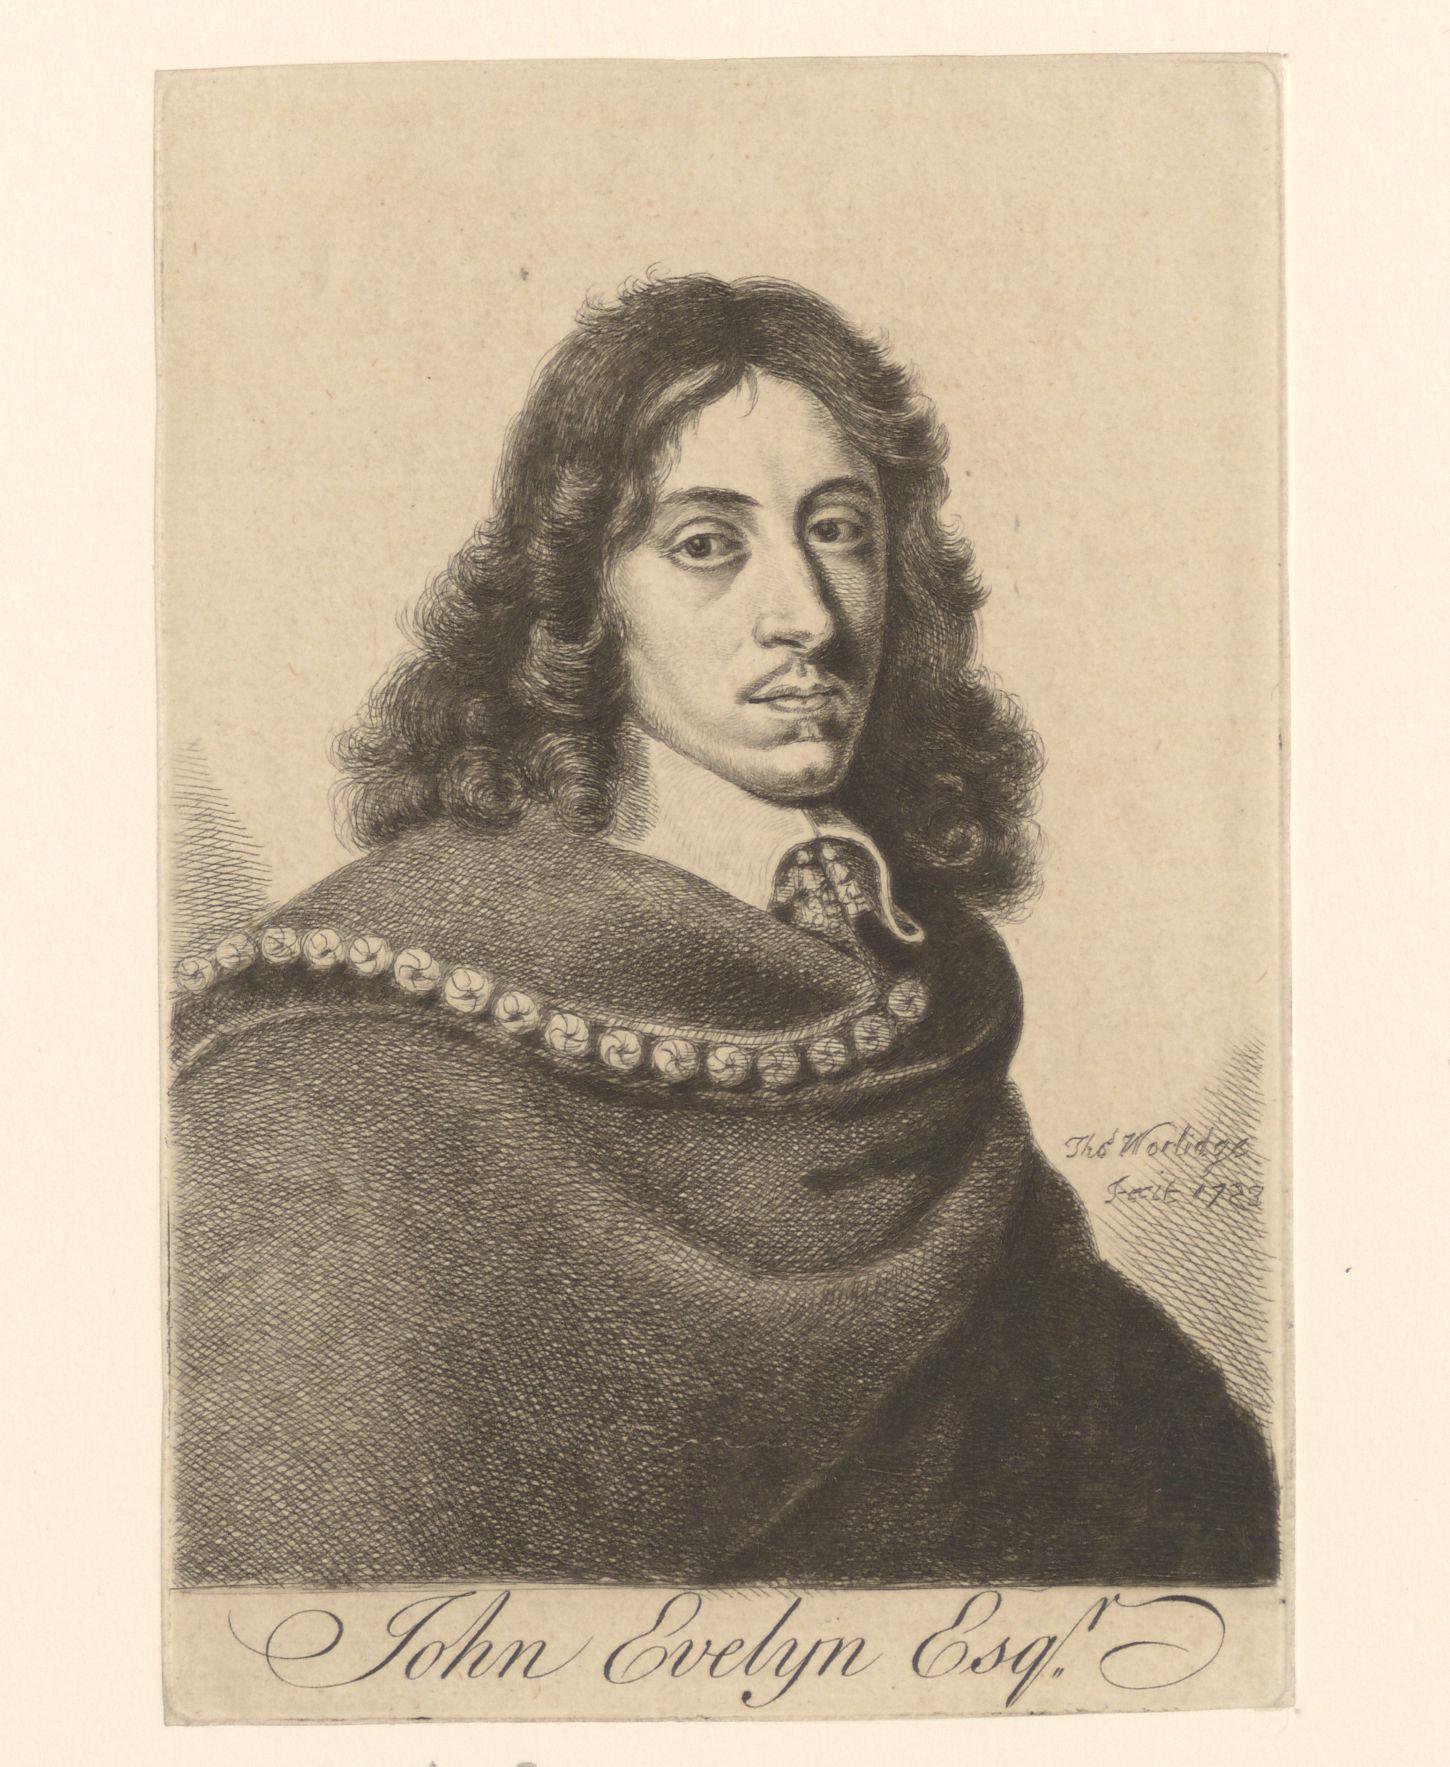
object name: print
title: Portret van John Evelyn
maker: thomas worlidge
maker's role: print maker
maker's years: 1700-1766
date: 1753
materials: paper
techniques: drypoint, etching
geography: london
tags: john evelyn, historical persons, portrait of a writer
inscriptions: collector's mark: Lugt 2228, collector's mark: Lugt 2760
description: Prent volgens O'Donoghue later gebruikt in: Evelyn, John. Sculptura, or the History and Art of Chalcography (...). S.l.s.n., 1755.